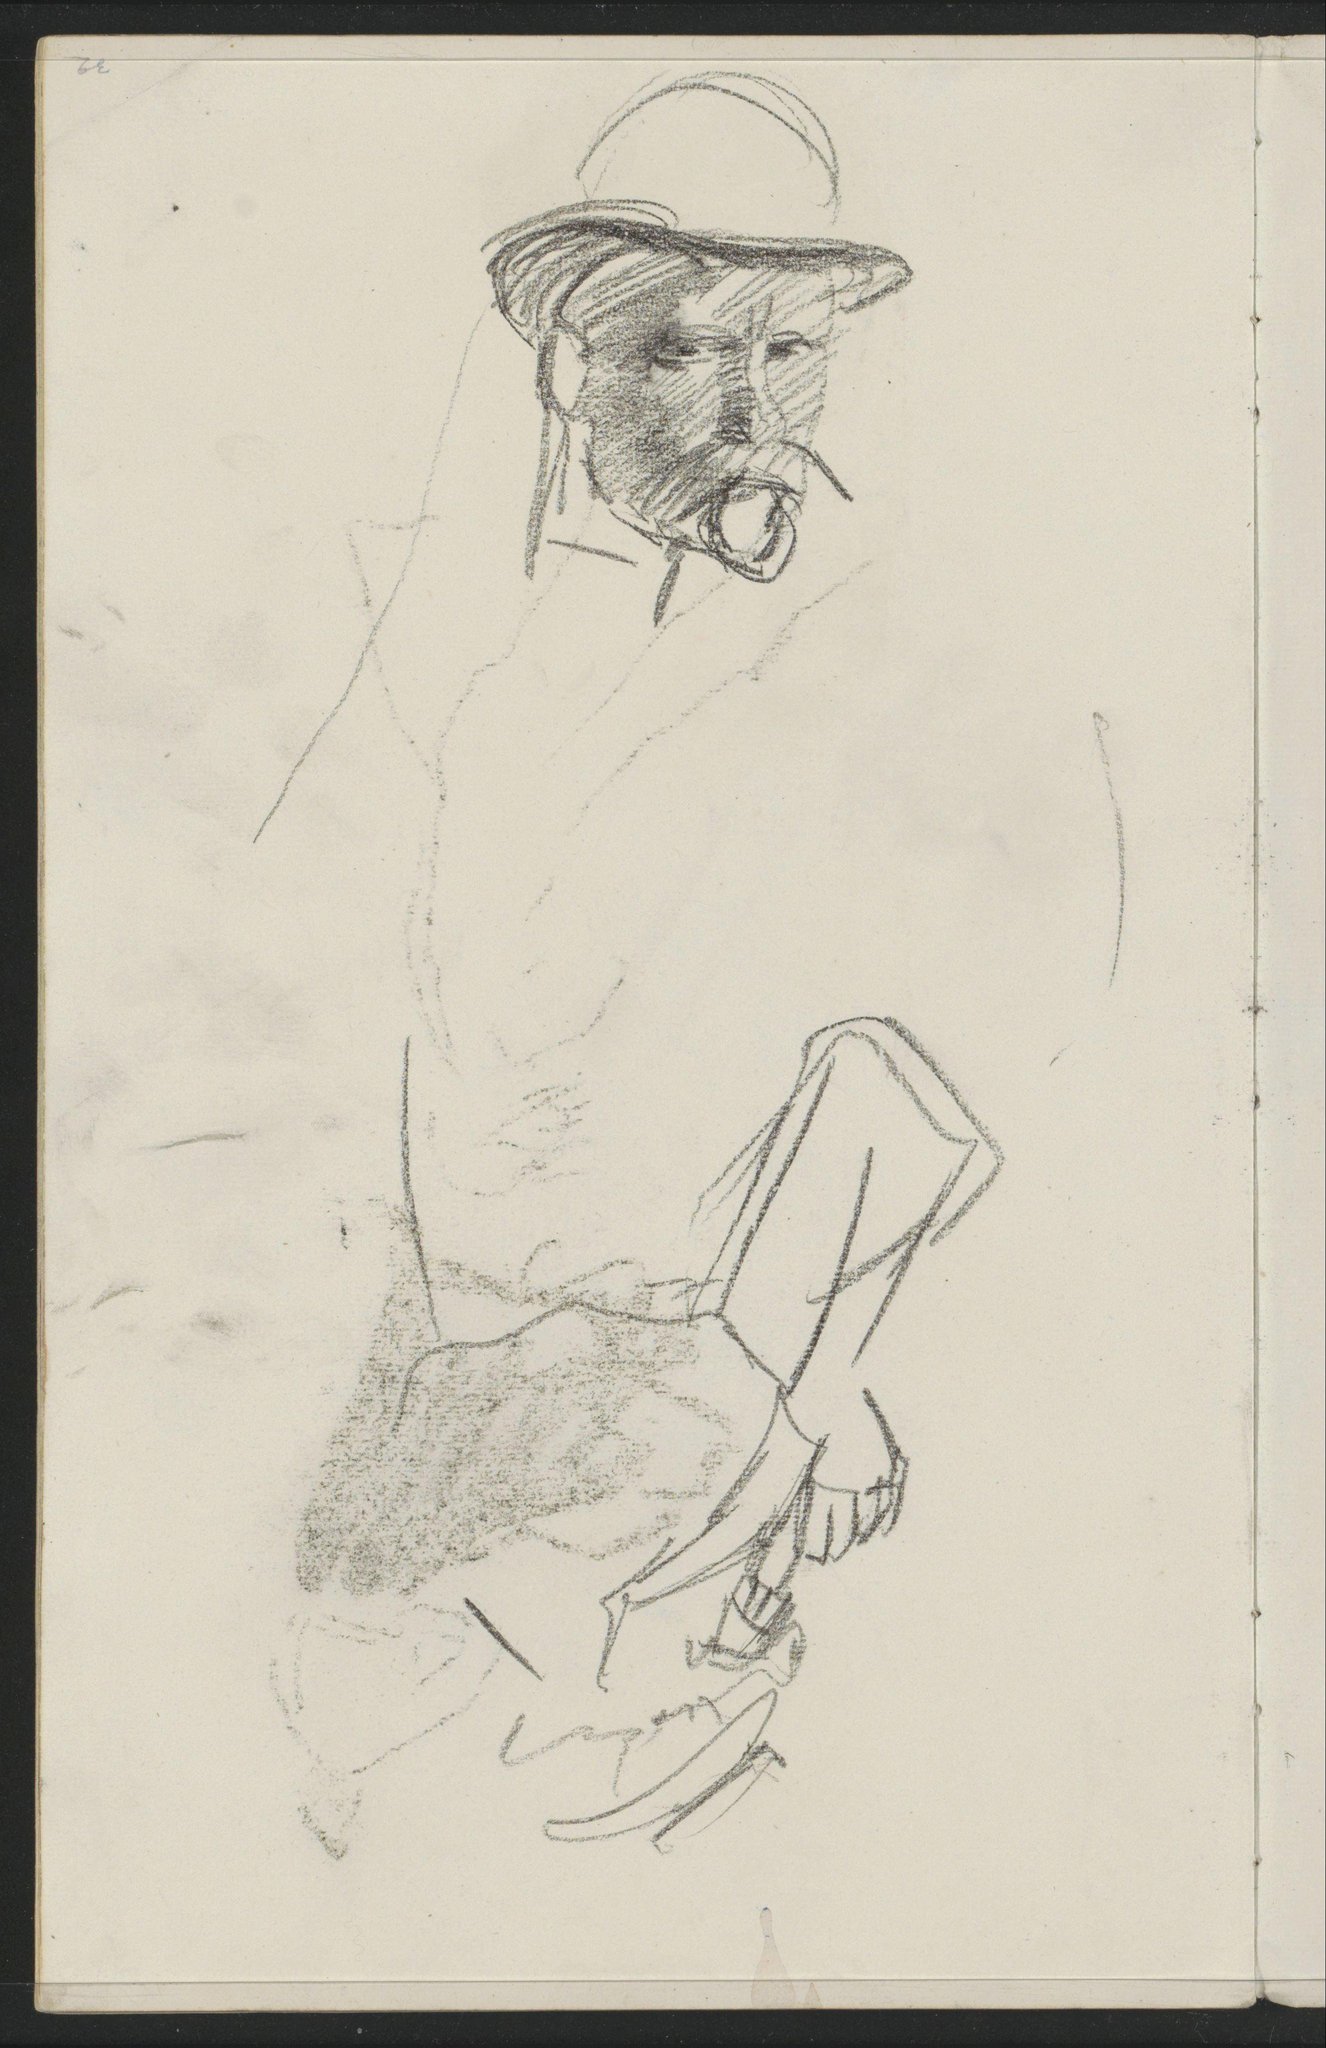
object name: sketchbook leaf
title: Zelfportret van Isaac Israels met hoed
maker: isaac israels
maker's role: draughtsman, painter, print maker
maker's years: 1865-1934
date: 1875-1934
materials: chalk, paper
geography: amsterdam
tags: the hague, painter, print maker, draughtsman, isaac israels, portrait, self-portrait of artist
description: Blad 29 verso uit schetsboek XI met 30 bladen.